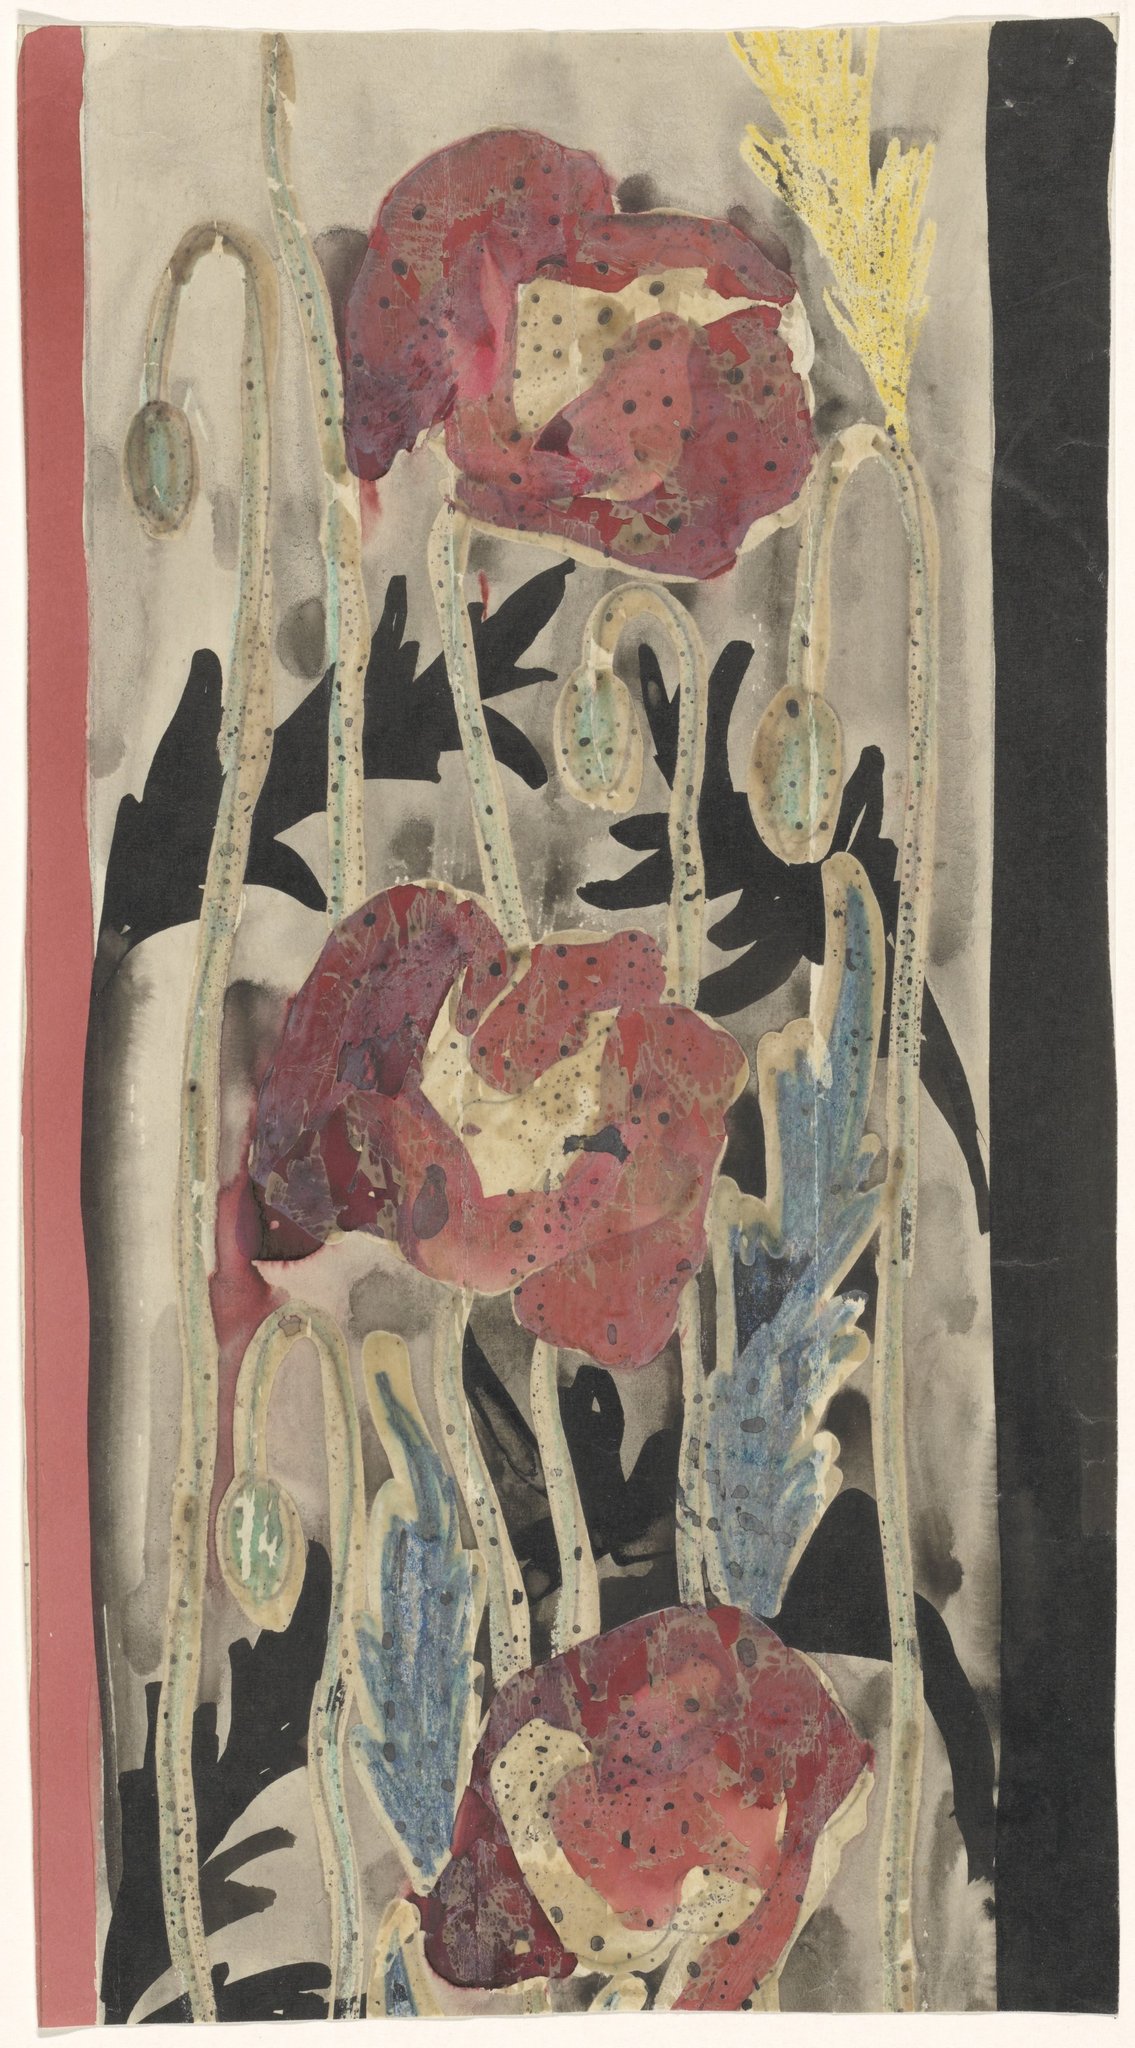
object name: design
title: Ontwerp met papavers voor de rand van het wandtapijt Gezicht op de Ponte Vecchio te Florence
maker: carel adolph lion cachet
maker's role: draughtsman, print maker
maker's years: 1864-1945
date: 1925-1926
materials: paper, pencil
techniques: brush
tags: flowers: poppy, flowers ~ ornament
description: Ontwerp voor het wandtapijt Gezicht op de Ponte Vecchio te Florence, voor de eetsalon van het schip de P.C. Hooft, uitgevoerd door J.F. Semey.